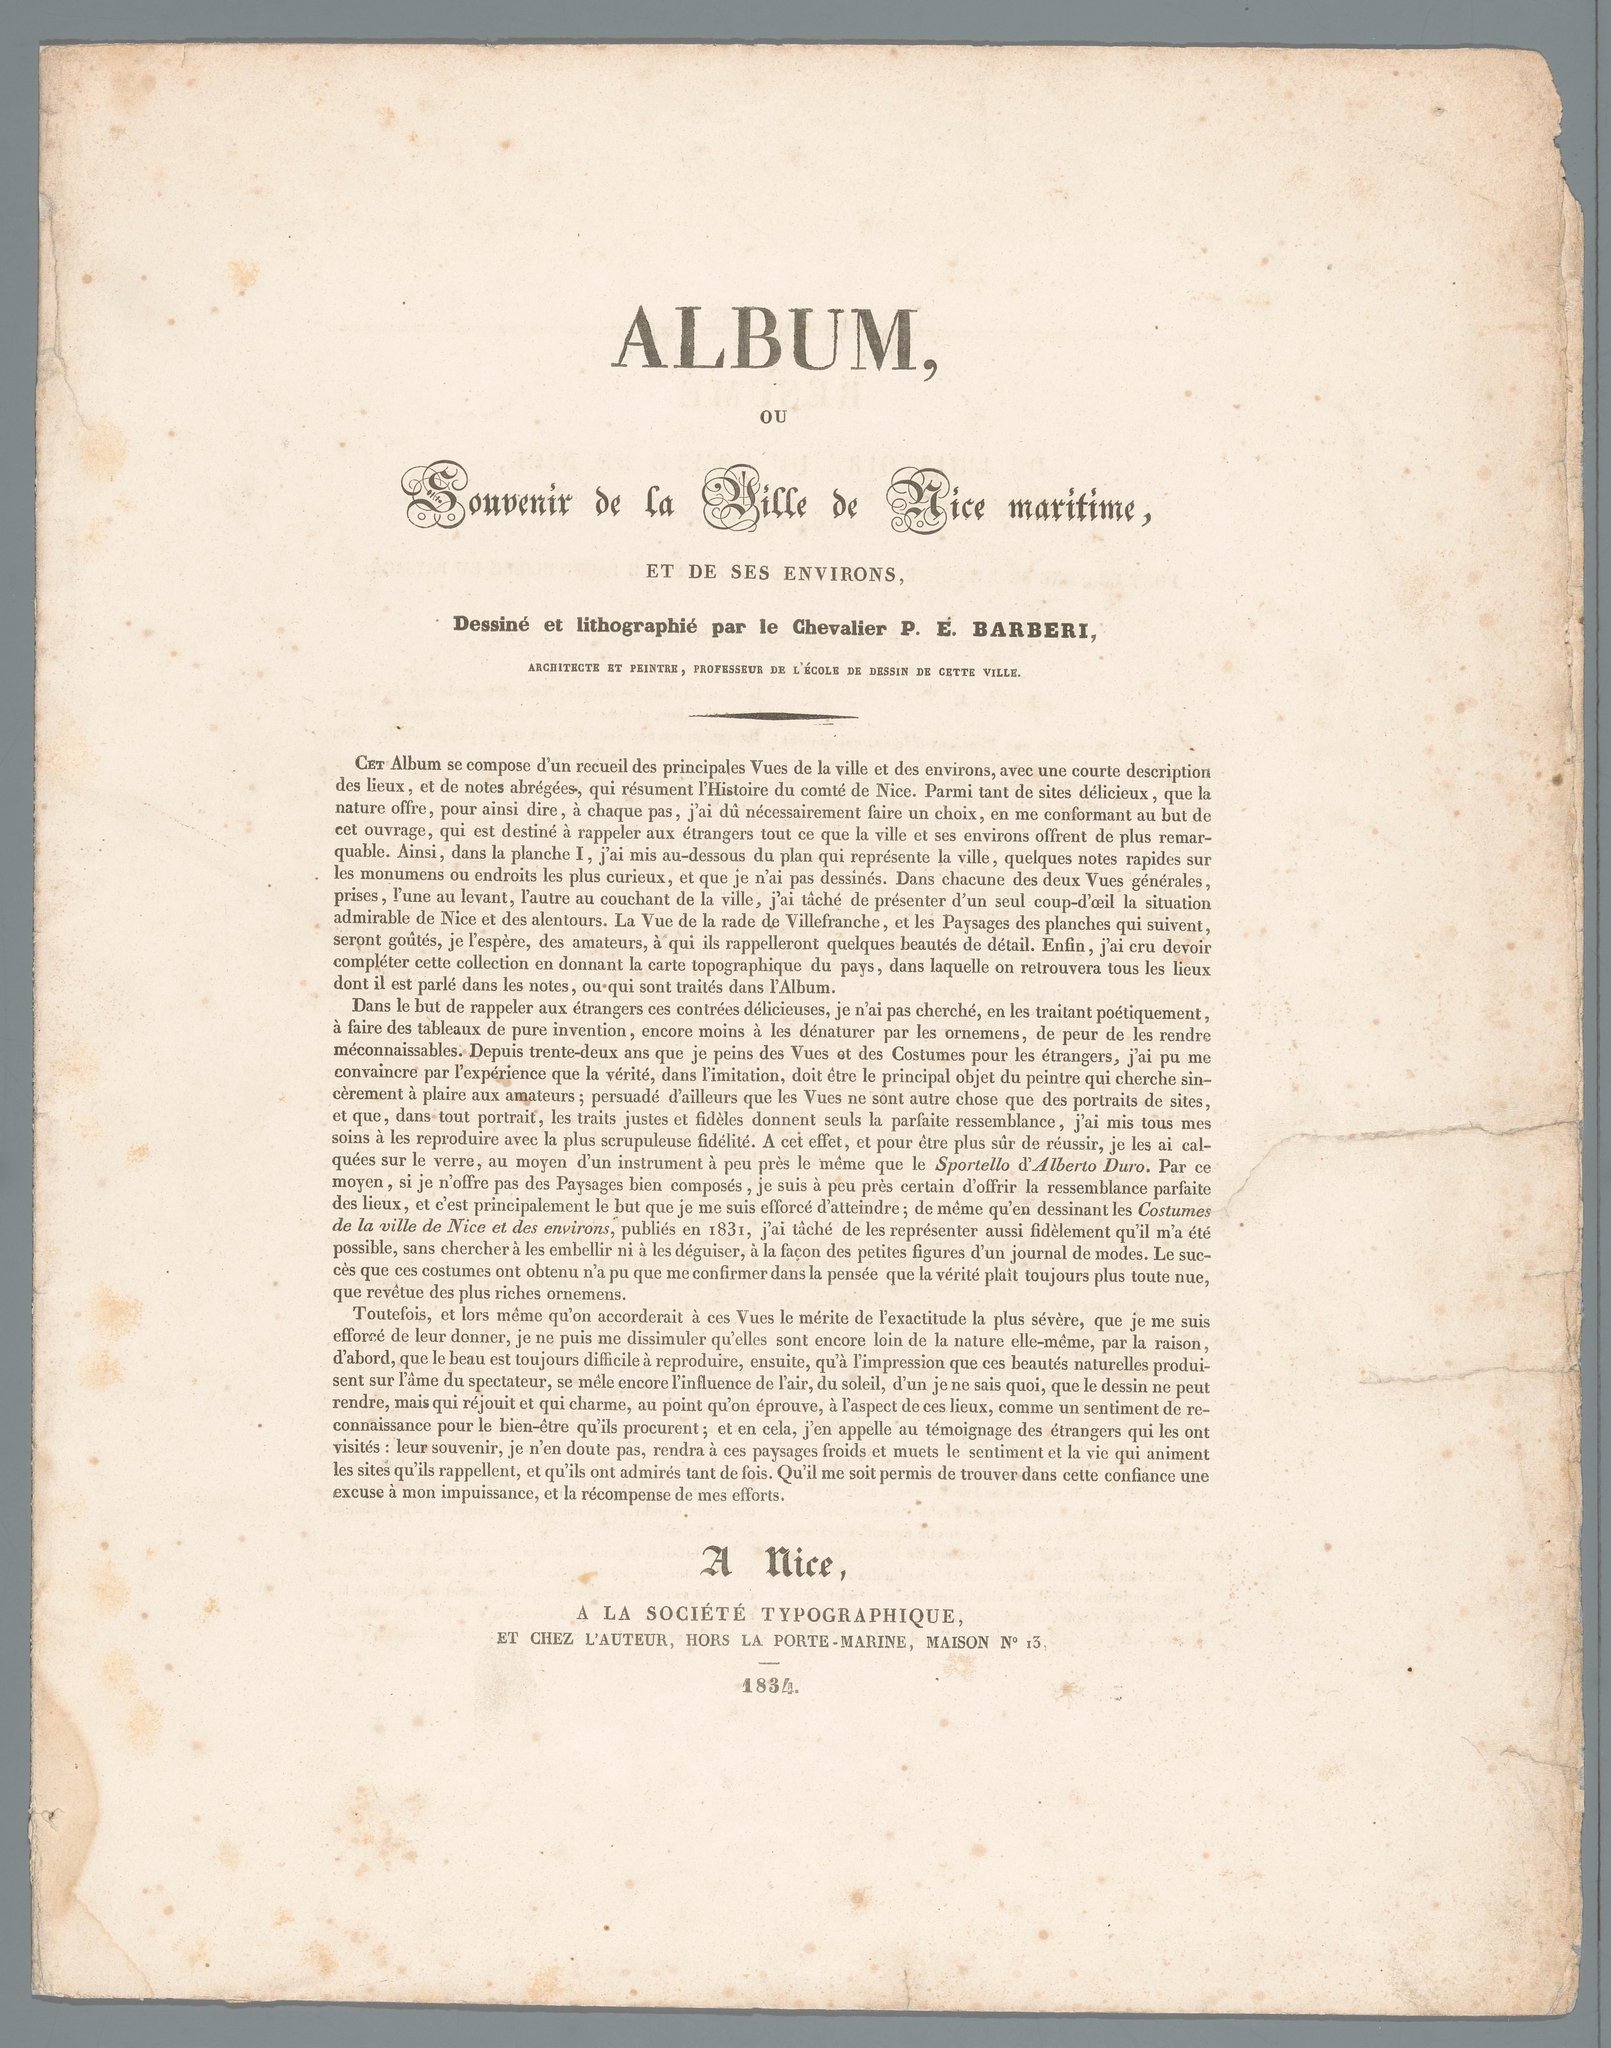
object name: print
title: Omslag voor: Herinneringen aan Nice en zijn kust, met kaart van Nice en omgeving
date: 1834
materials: paper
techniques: lithograph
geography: paris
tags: maps of separate countries or regions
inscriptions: collector's mark: Lugt 2228a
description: De prent bevindt zich aan de binnenzijde van de omslag. Deze omslag bevat de tekst 'Résumé de l'histoire du comté de Nice' (noot 1 t/m 8) en vier losse prenten.